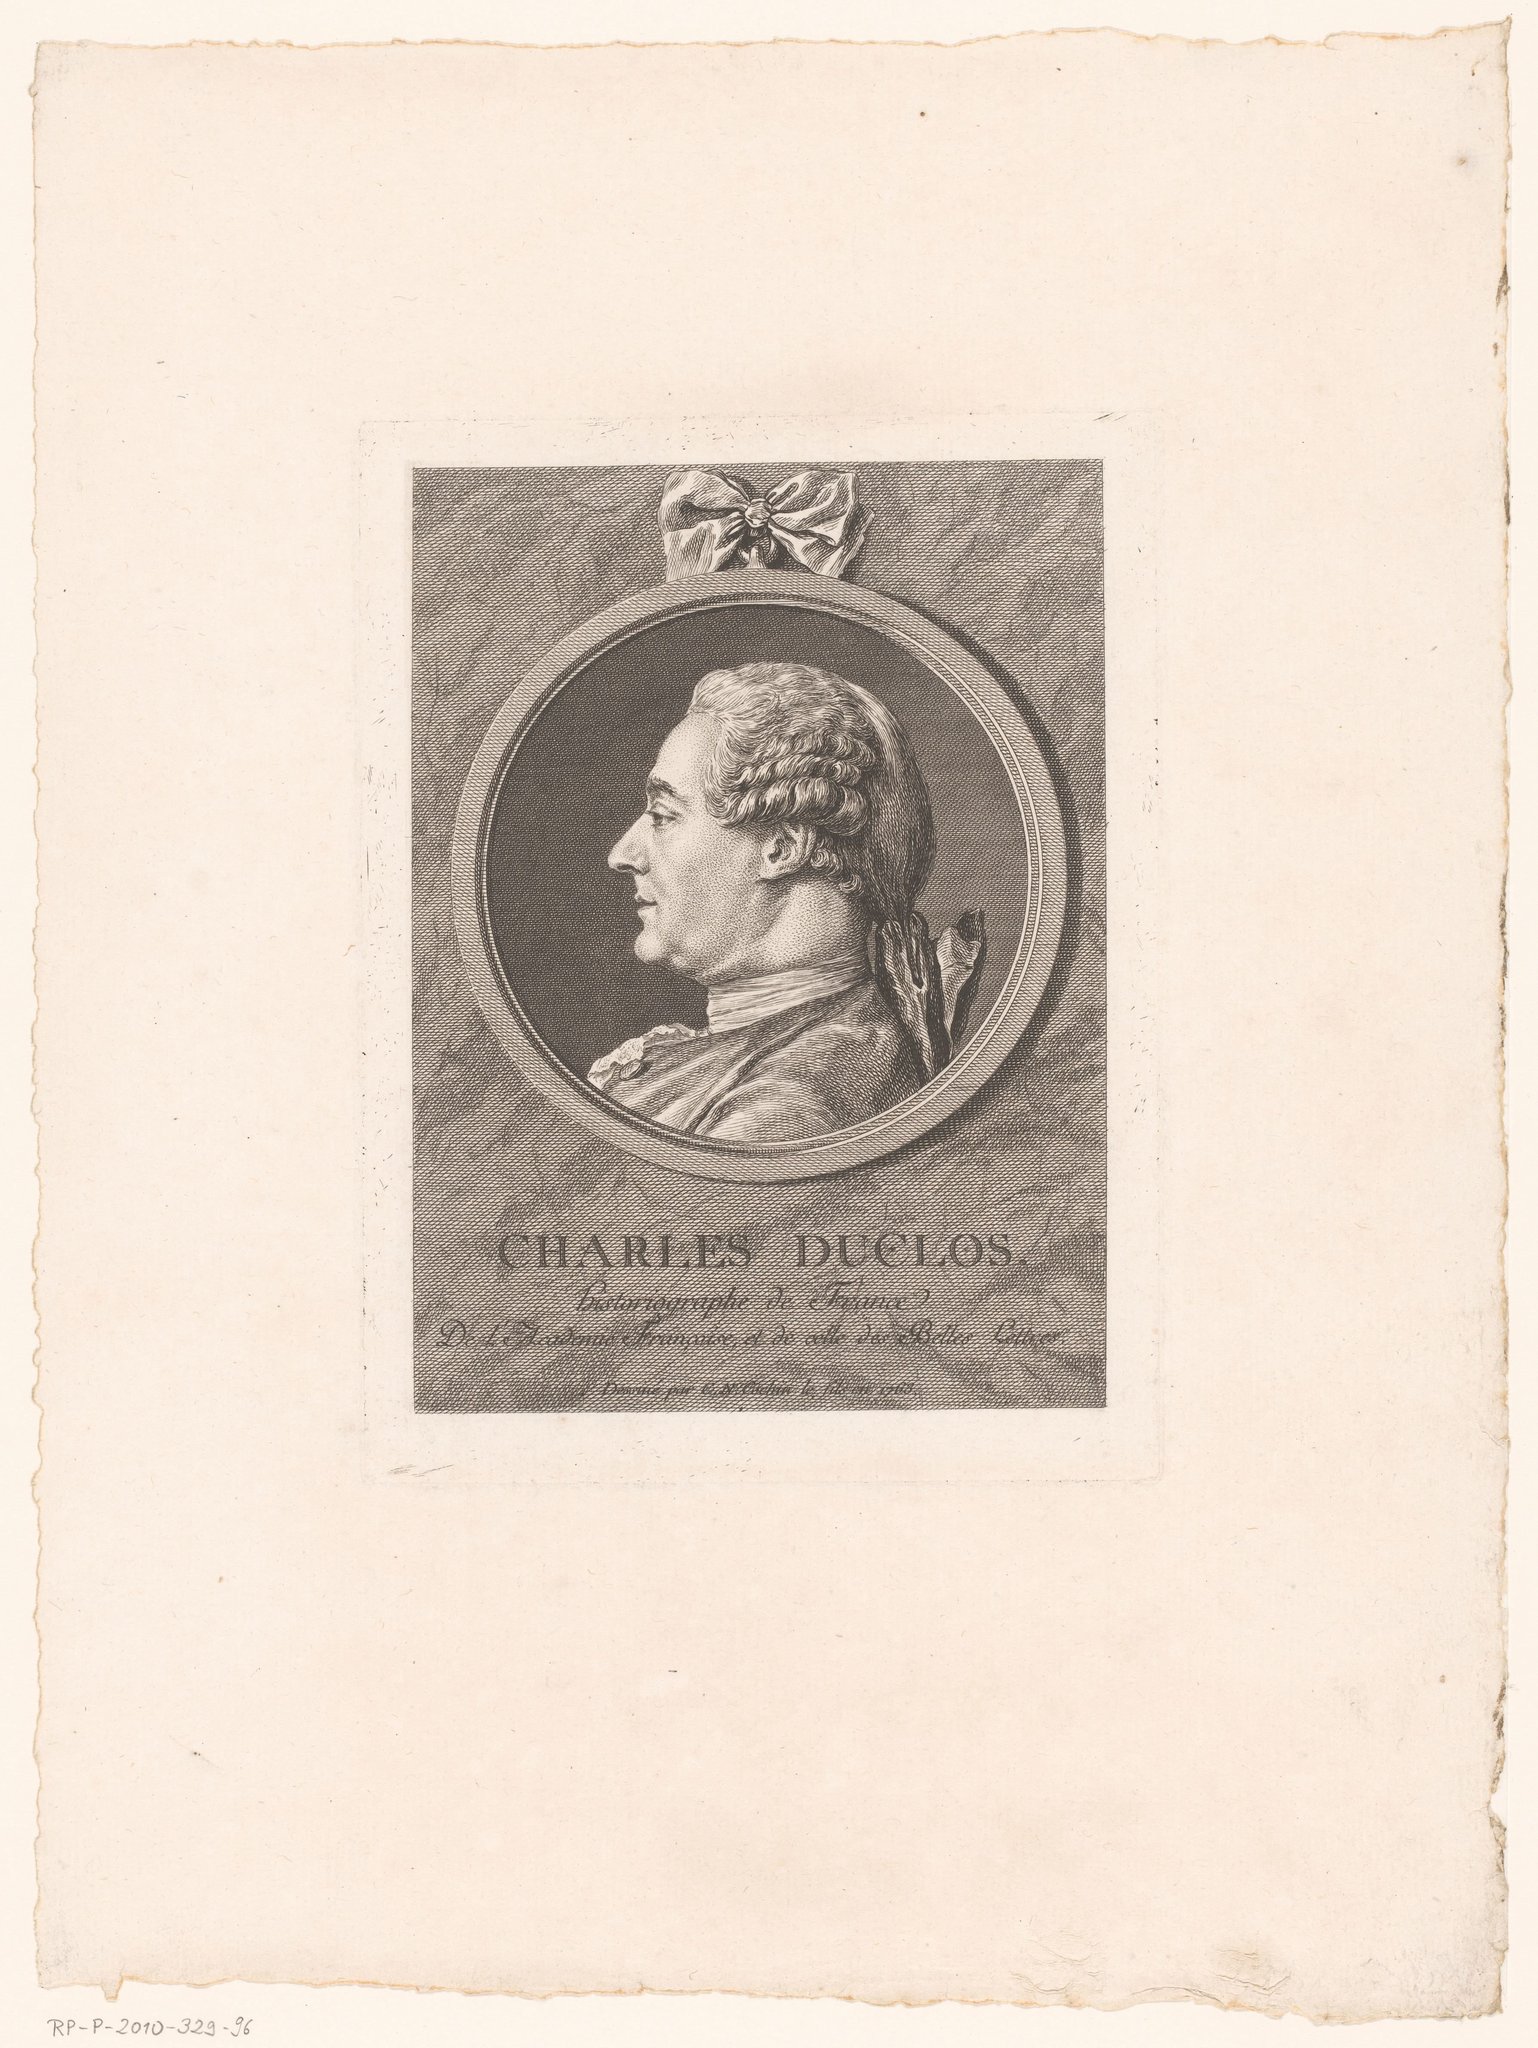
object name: print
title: Charles Duclos.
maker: charles nicolas cochin (ii)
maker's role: draughtsman, print maker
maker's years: 1715-1790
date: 1763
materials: paper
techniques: engraving, etching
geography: france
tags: paris, ornament ~ medallion, historical persons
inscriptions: collector's mark: Lugt 2228